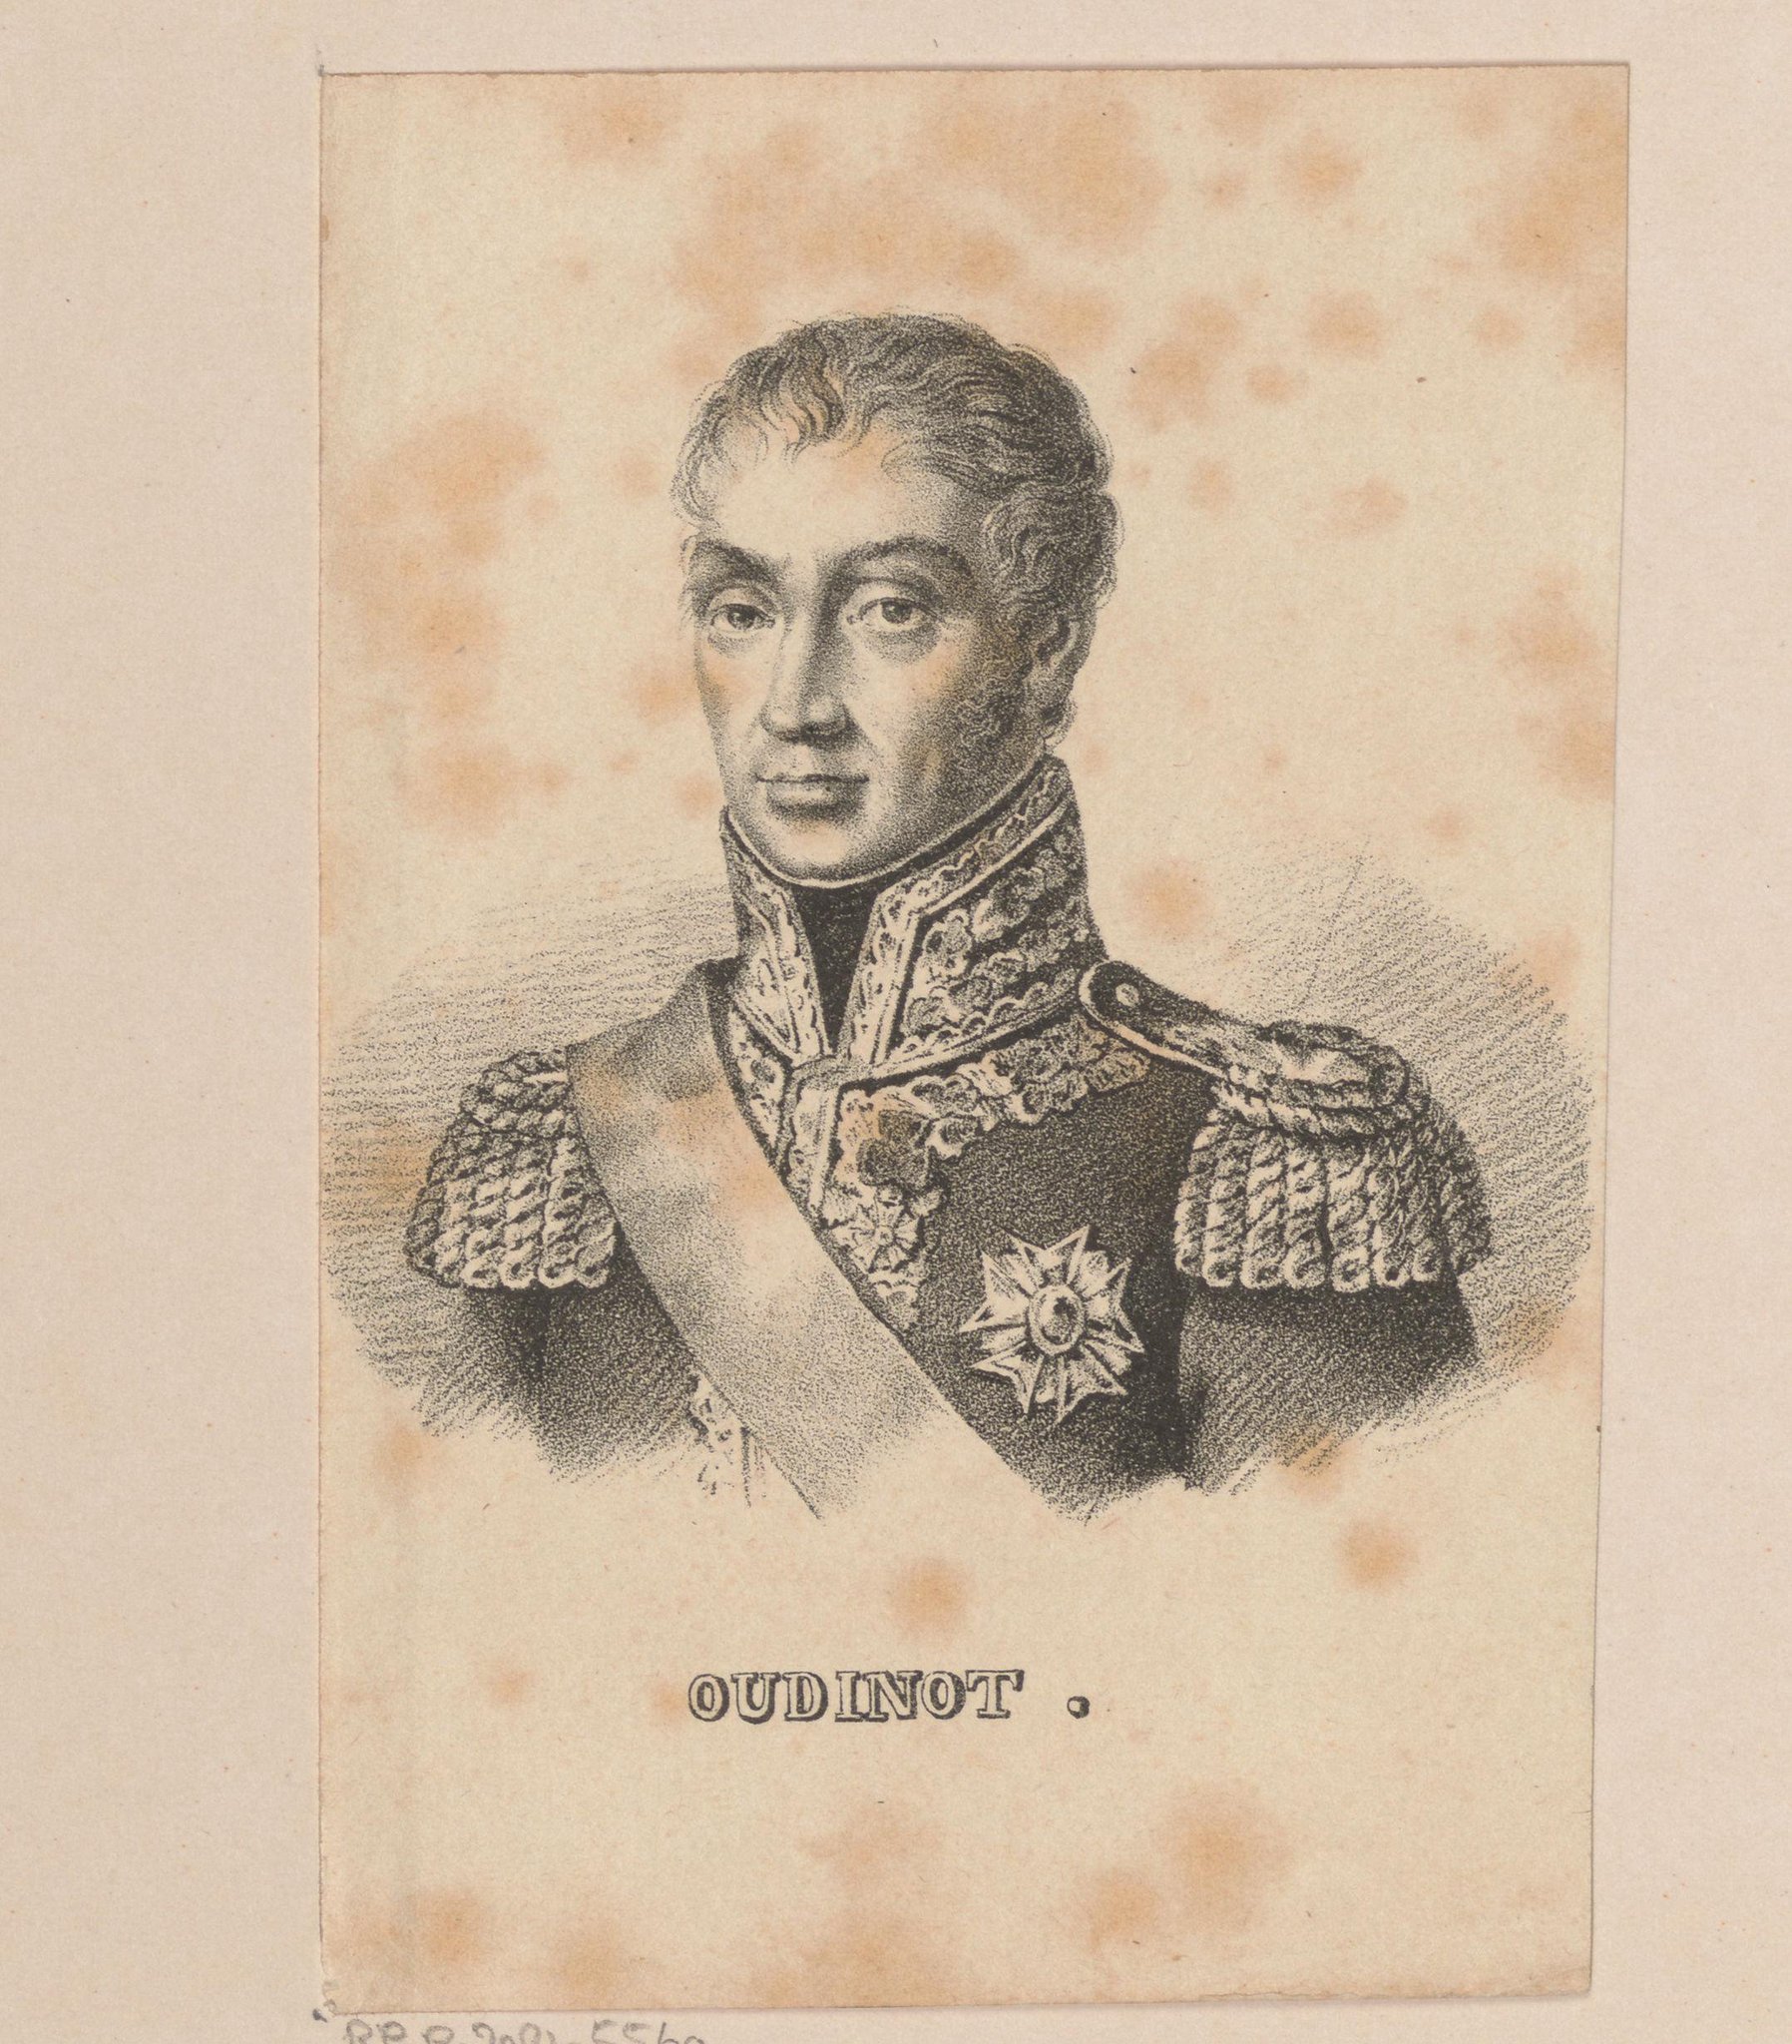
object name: print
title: Portret van Nicolas-Charles-Marie Oudinot, hertog van Reggio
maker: Anonymous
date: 1795-1899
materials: paper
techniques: lithograph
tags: paris, historical persons, medals and other marks of military honour